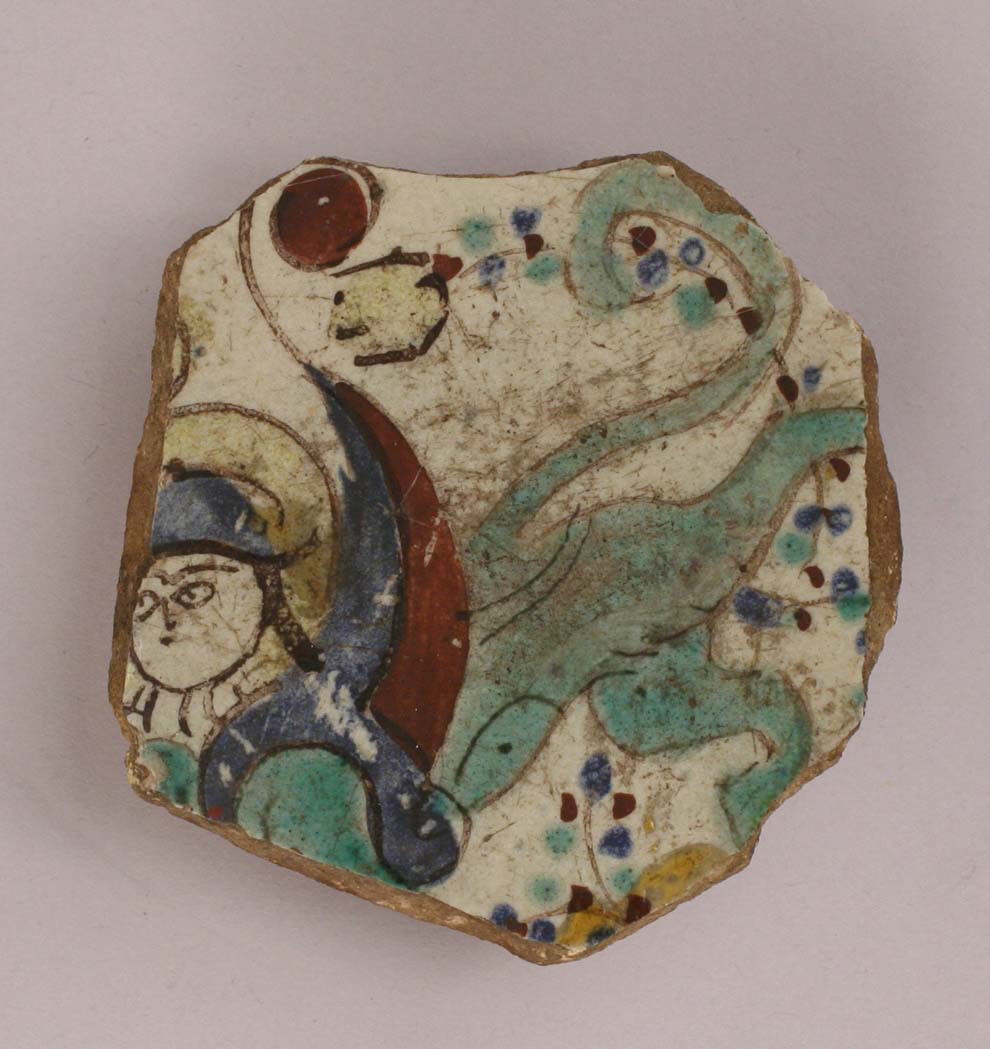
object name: fragment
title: Fragment of a Bowl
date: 1101-1300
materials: stonepaste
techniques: overglaze, painting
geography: iran